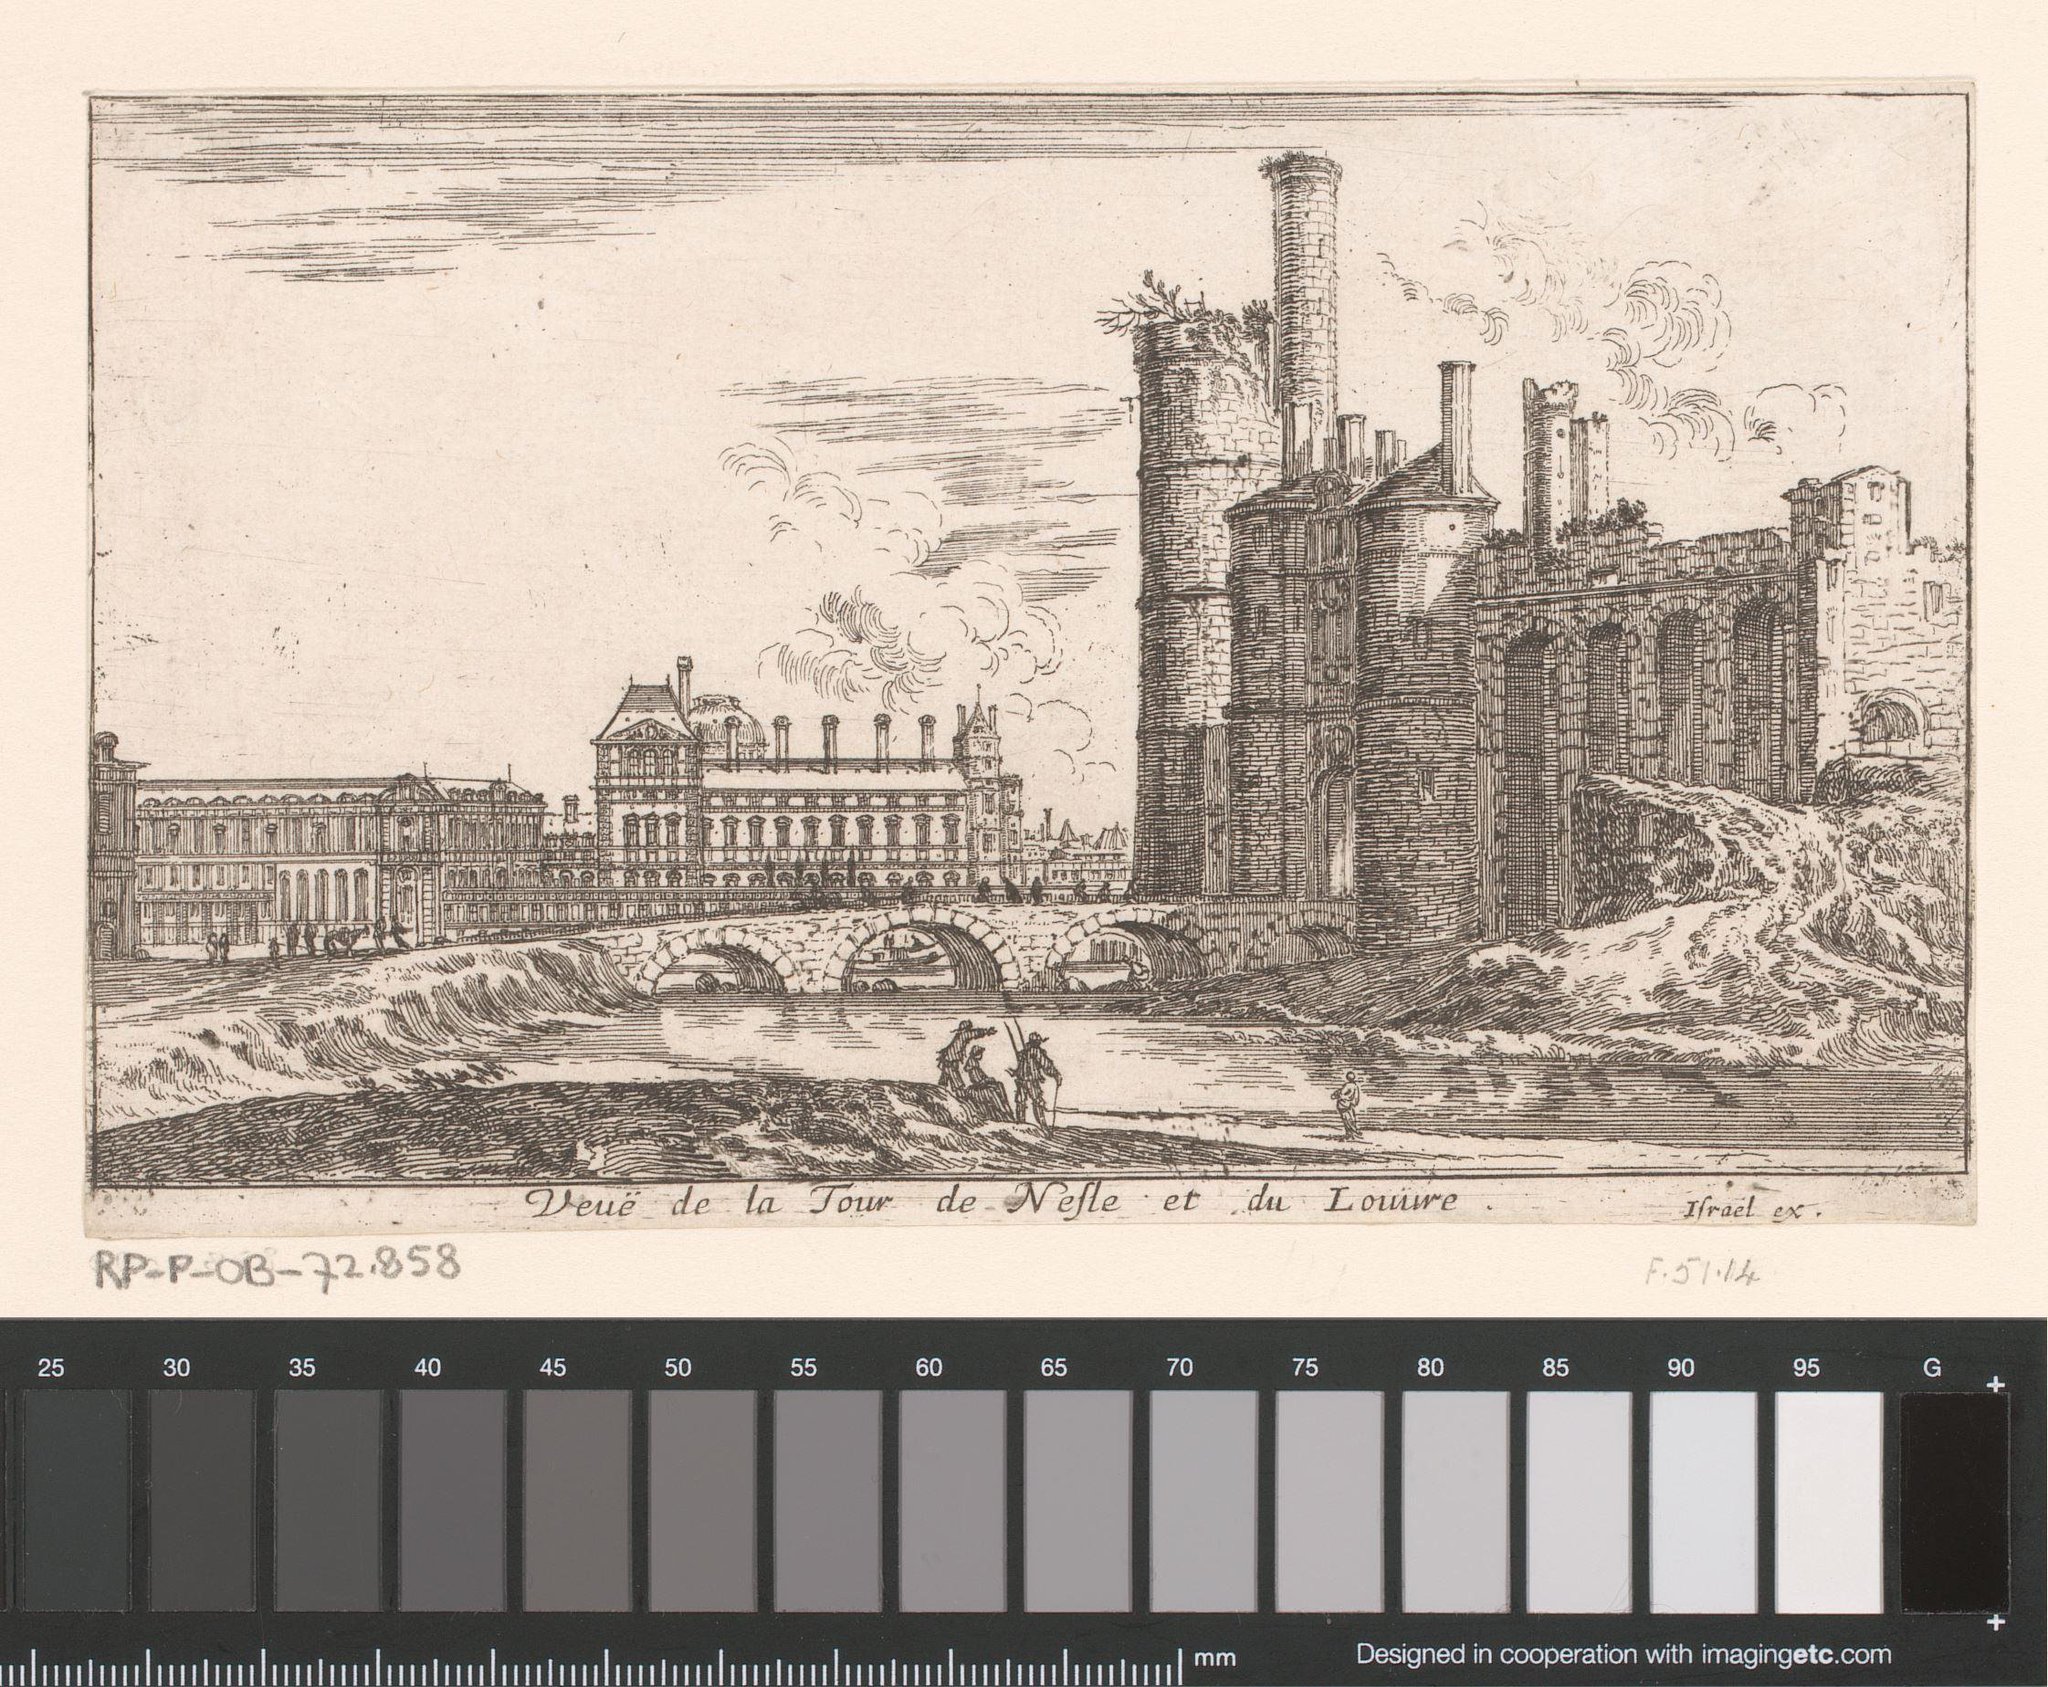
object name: print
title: Diverses veuës faictes sur le naturel par Israel Silvestre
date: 1652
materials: paper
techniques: etching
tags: landscape with tower or castle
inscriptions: collector's mark: Lugt 240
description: Prent maakt deel uit van een ongenummerde serie van twintig prenten.